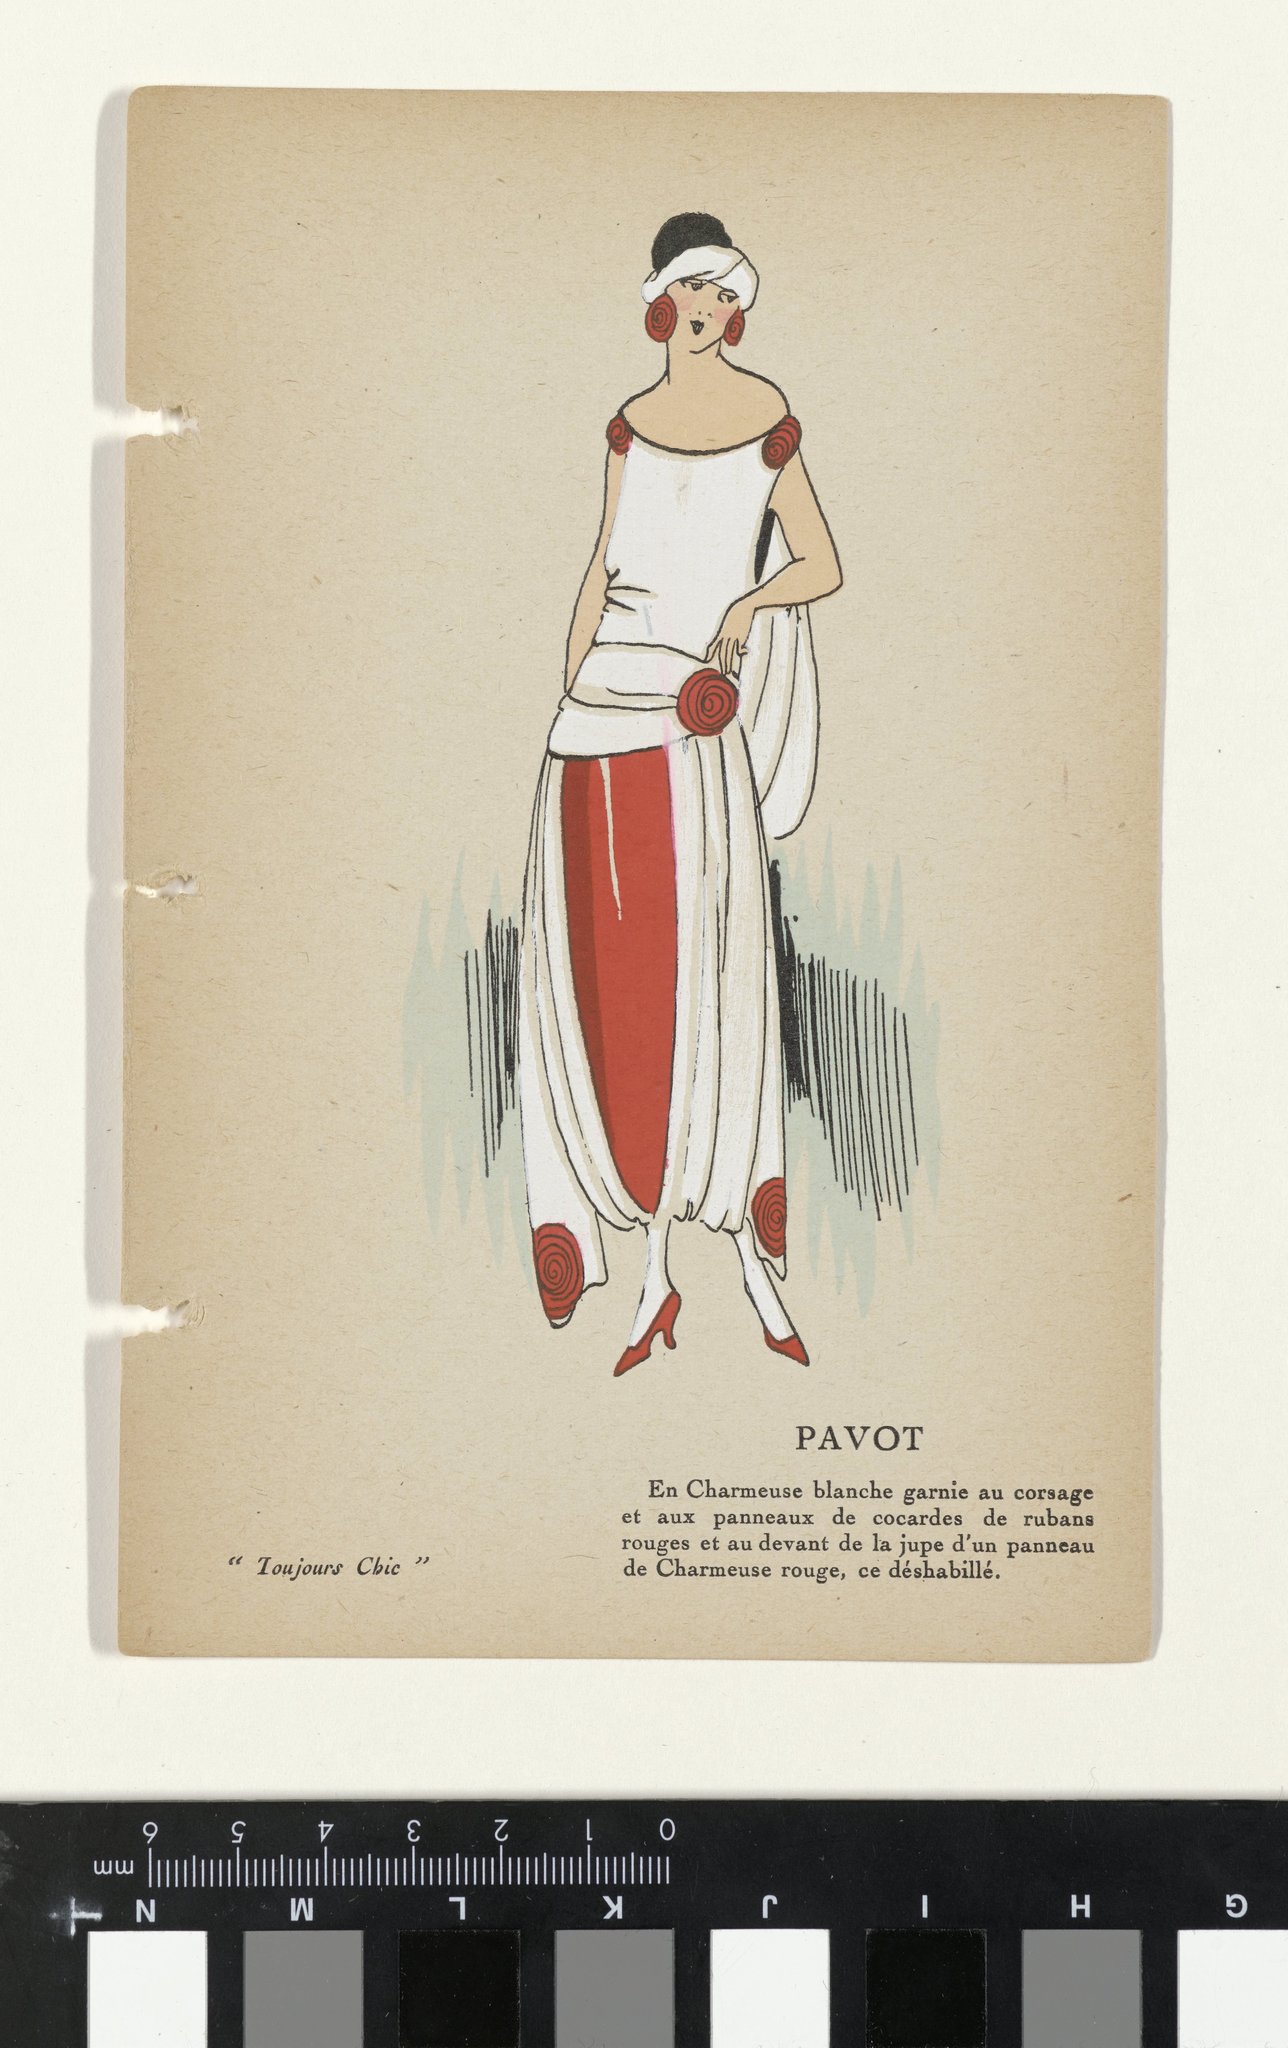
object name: fashion print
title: Toujours Chic Les Deshabillés, Hiver 1921-1922: Pavot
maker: g-p. joumard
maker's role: publisher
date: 1921-1922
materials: paper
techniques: letterpress printing, pochoir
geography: paris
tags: fashion plates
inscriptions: date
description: Prent uit Catalogus "Toujours Chic" waarin een overzicht van de wintermode 1921-1922.